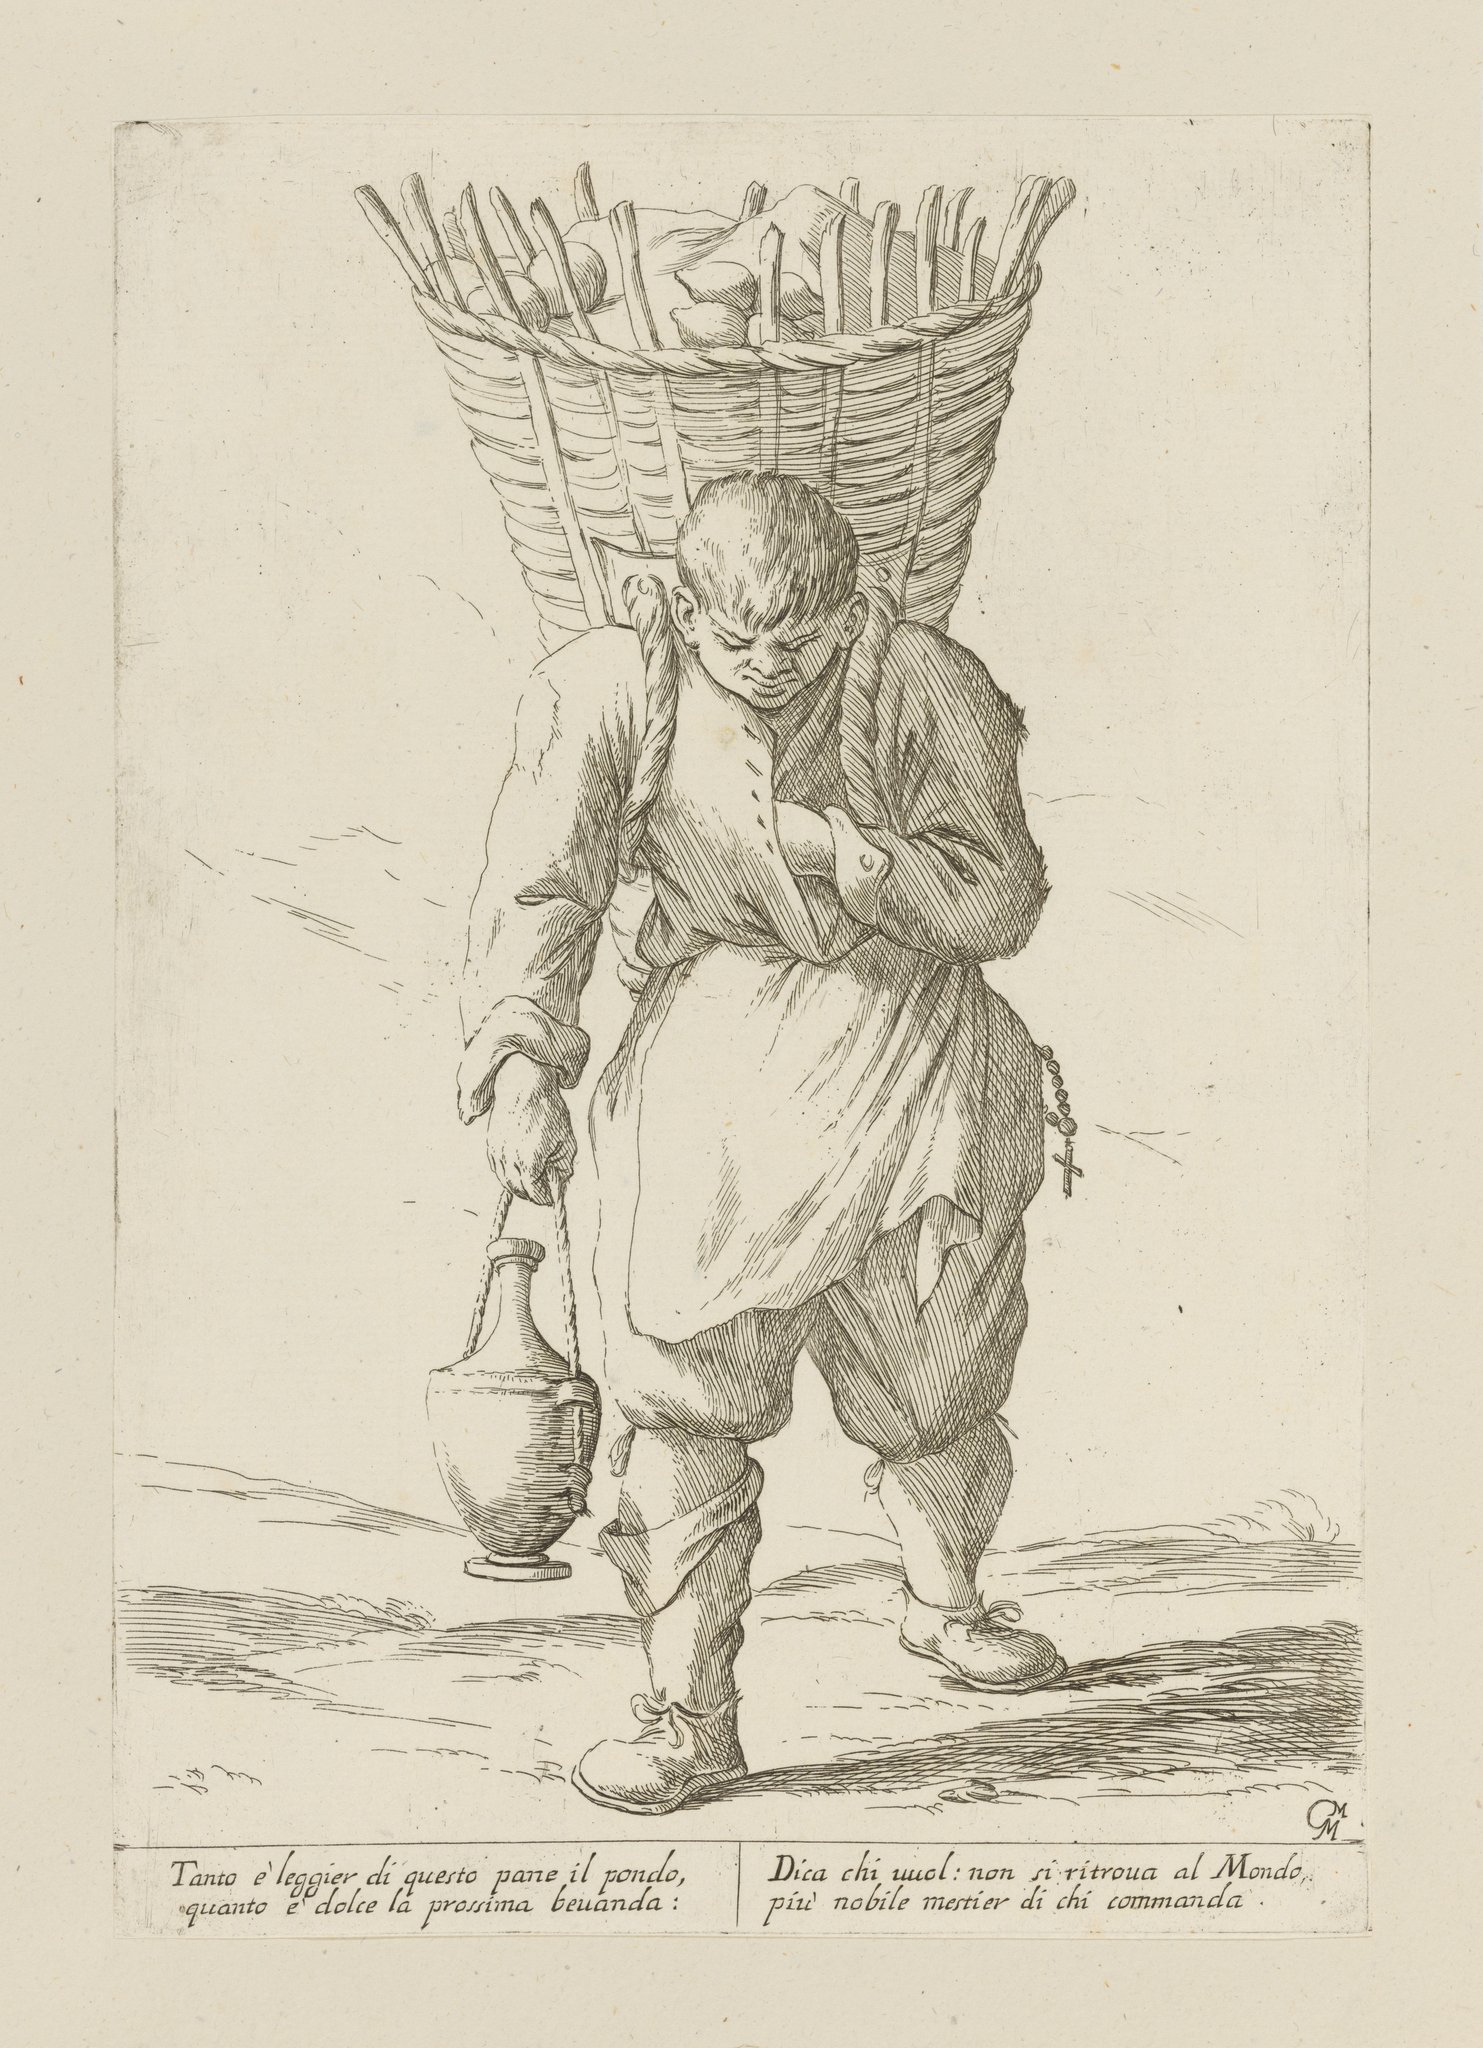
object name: print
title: Man Carrying Bread in a Basket, from Di Bologna l'Arti per via D'An.ibal' Ca.rac, plate 35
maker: giuseppe maria mitelli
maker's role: artist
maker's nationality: italian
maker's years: 1634-1718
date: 1660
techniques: etching